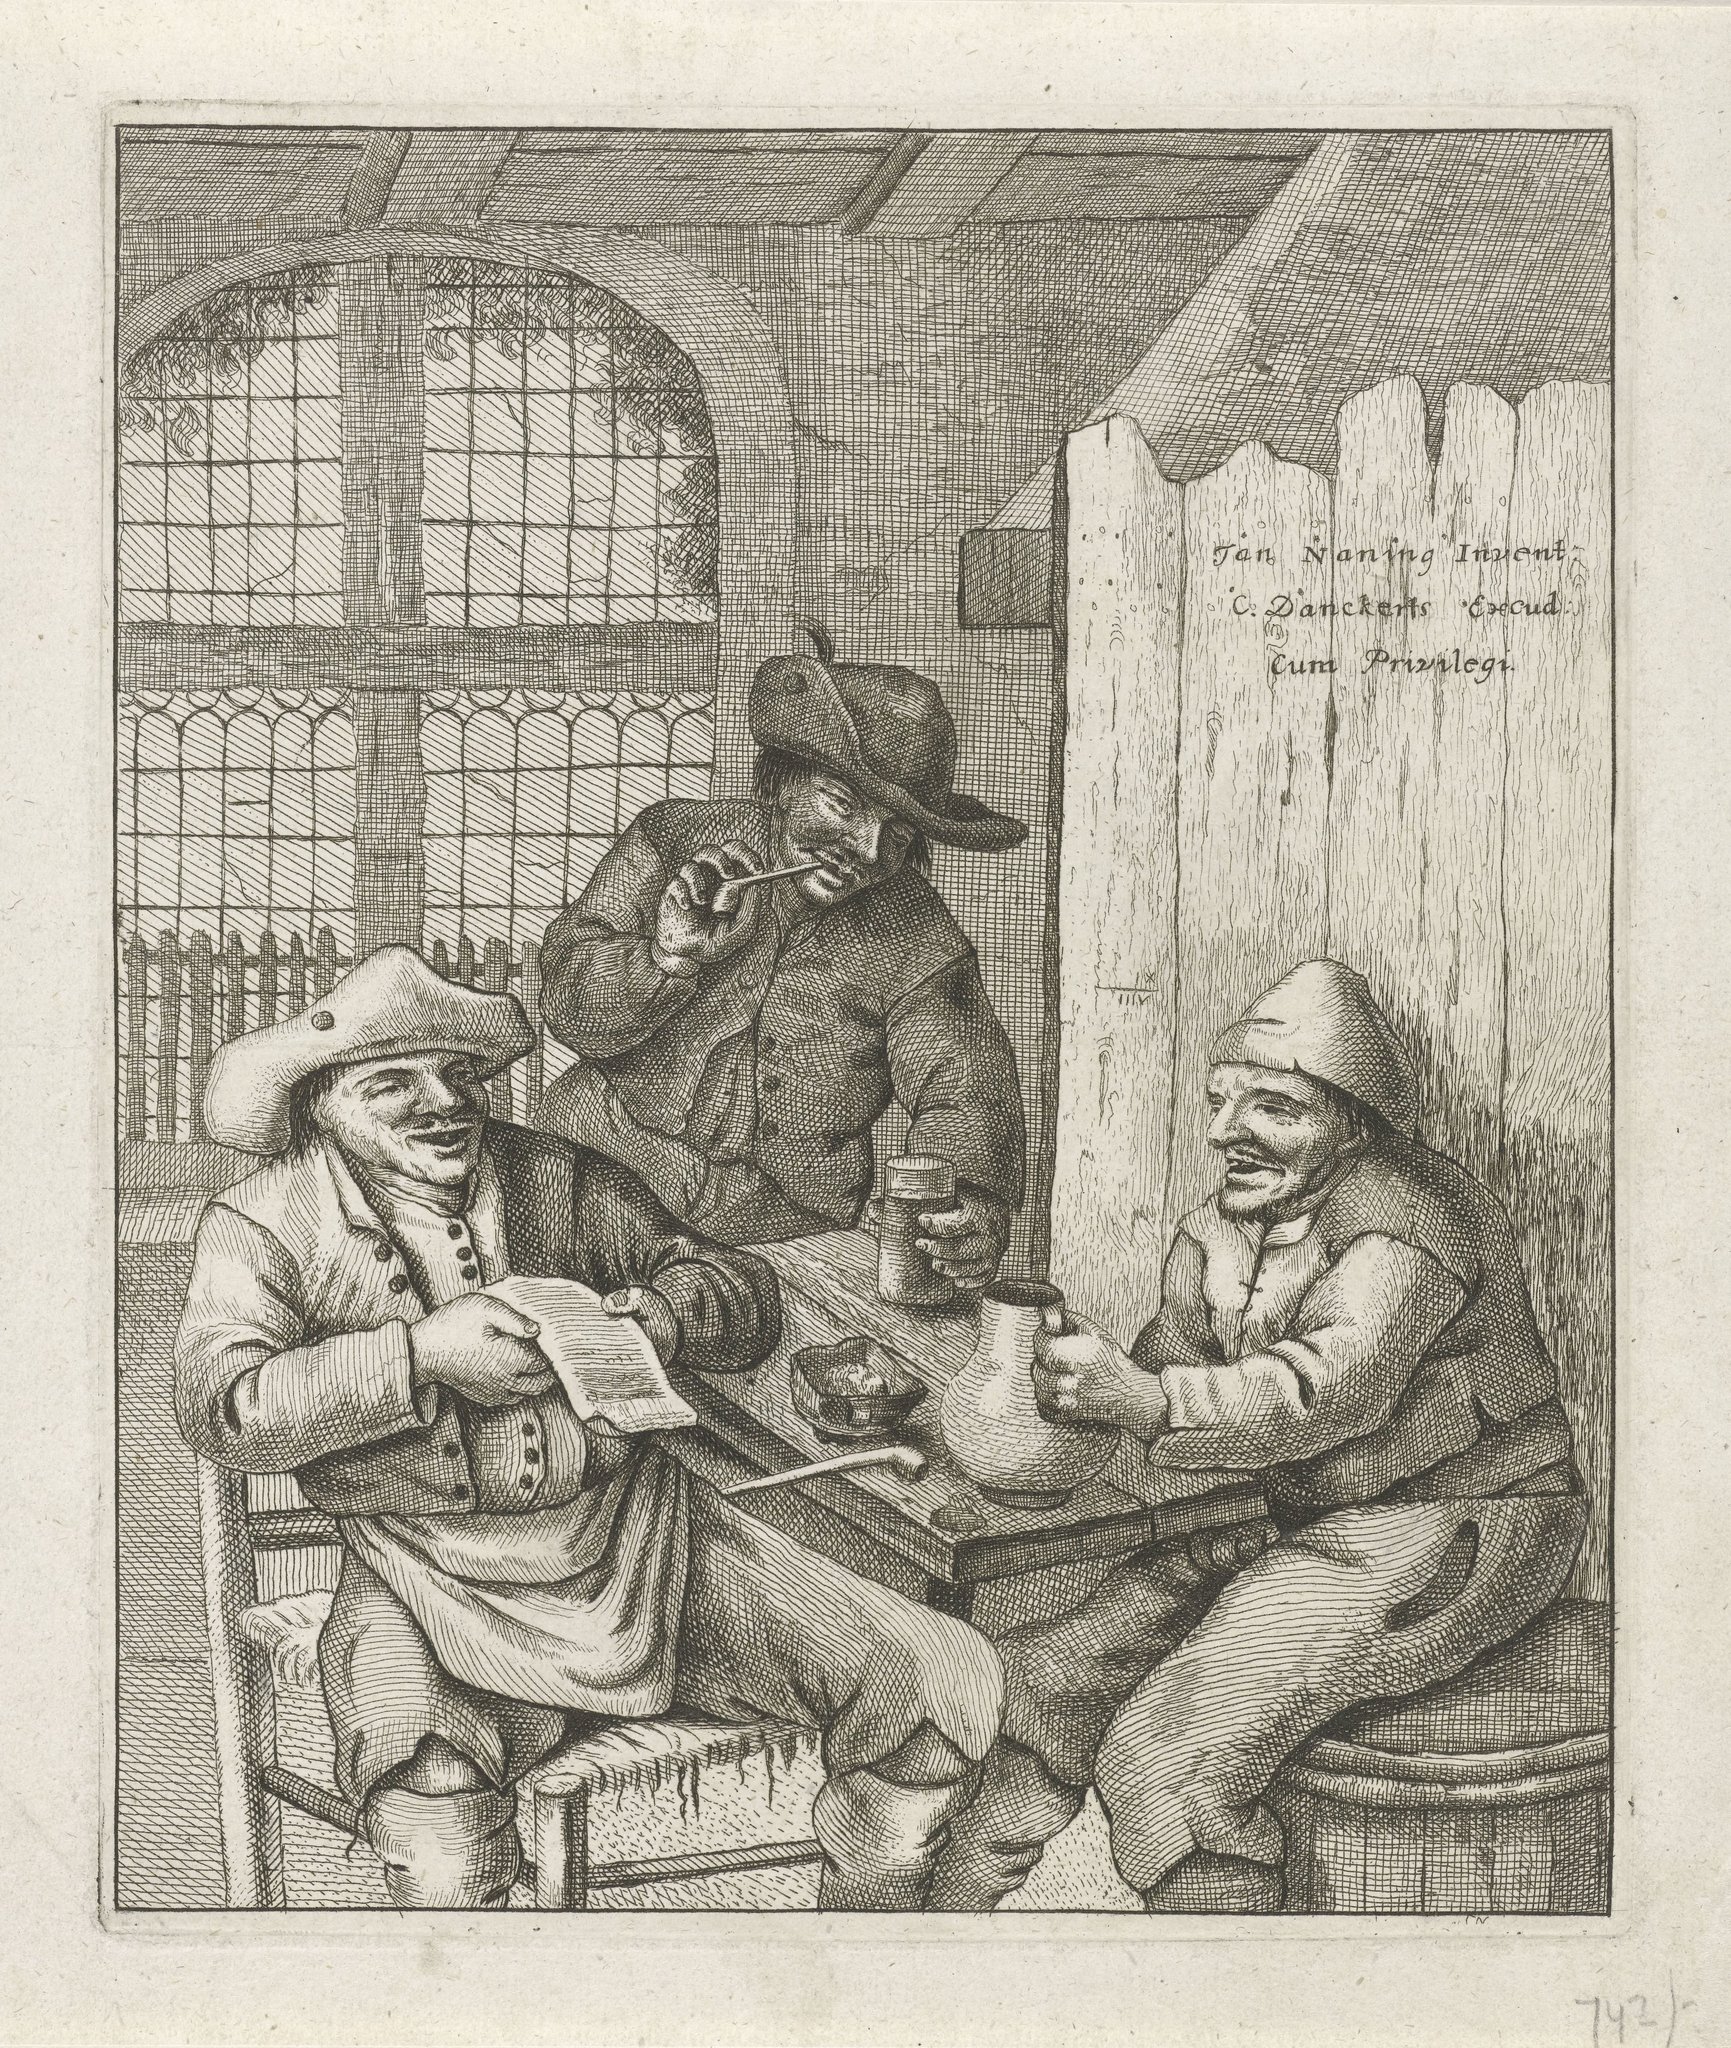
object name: print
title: Boerengezelschap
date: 1650-1699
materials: paper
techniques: engraving, etching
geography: amsterdam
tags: pipe ~ tobacco, farmers, drinking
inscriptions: collector's mark: Lugt 2760, collector's mark: Lugt 2228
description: Drie boeren om een tafel. De boer links zit wijdbeens en houdt een papier in zijn handen. De boer in het midden rookt pijp, een drinkbeker in de hand. De boer rechts houdt een kruik vast. Op de achtergrond een venster.